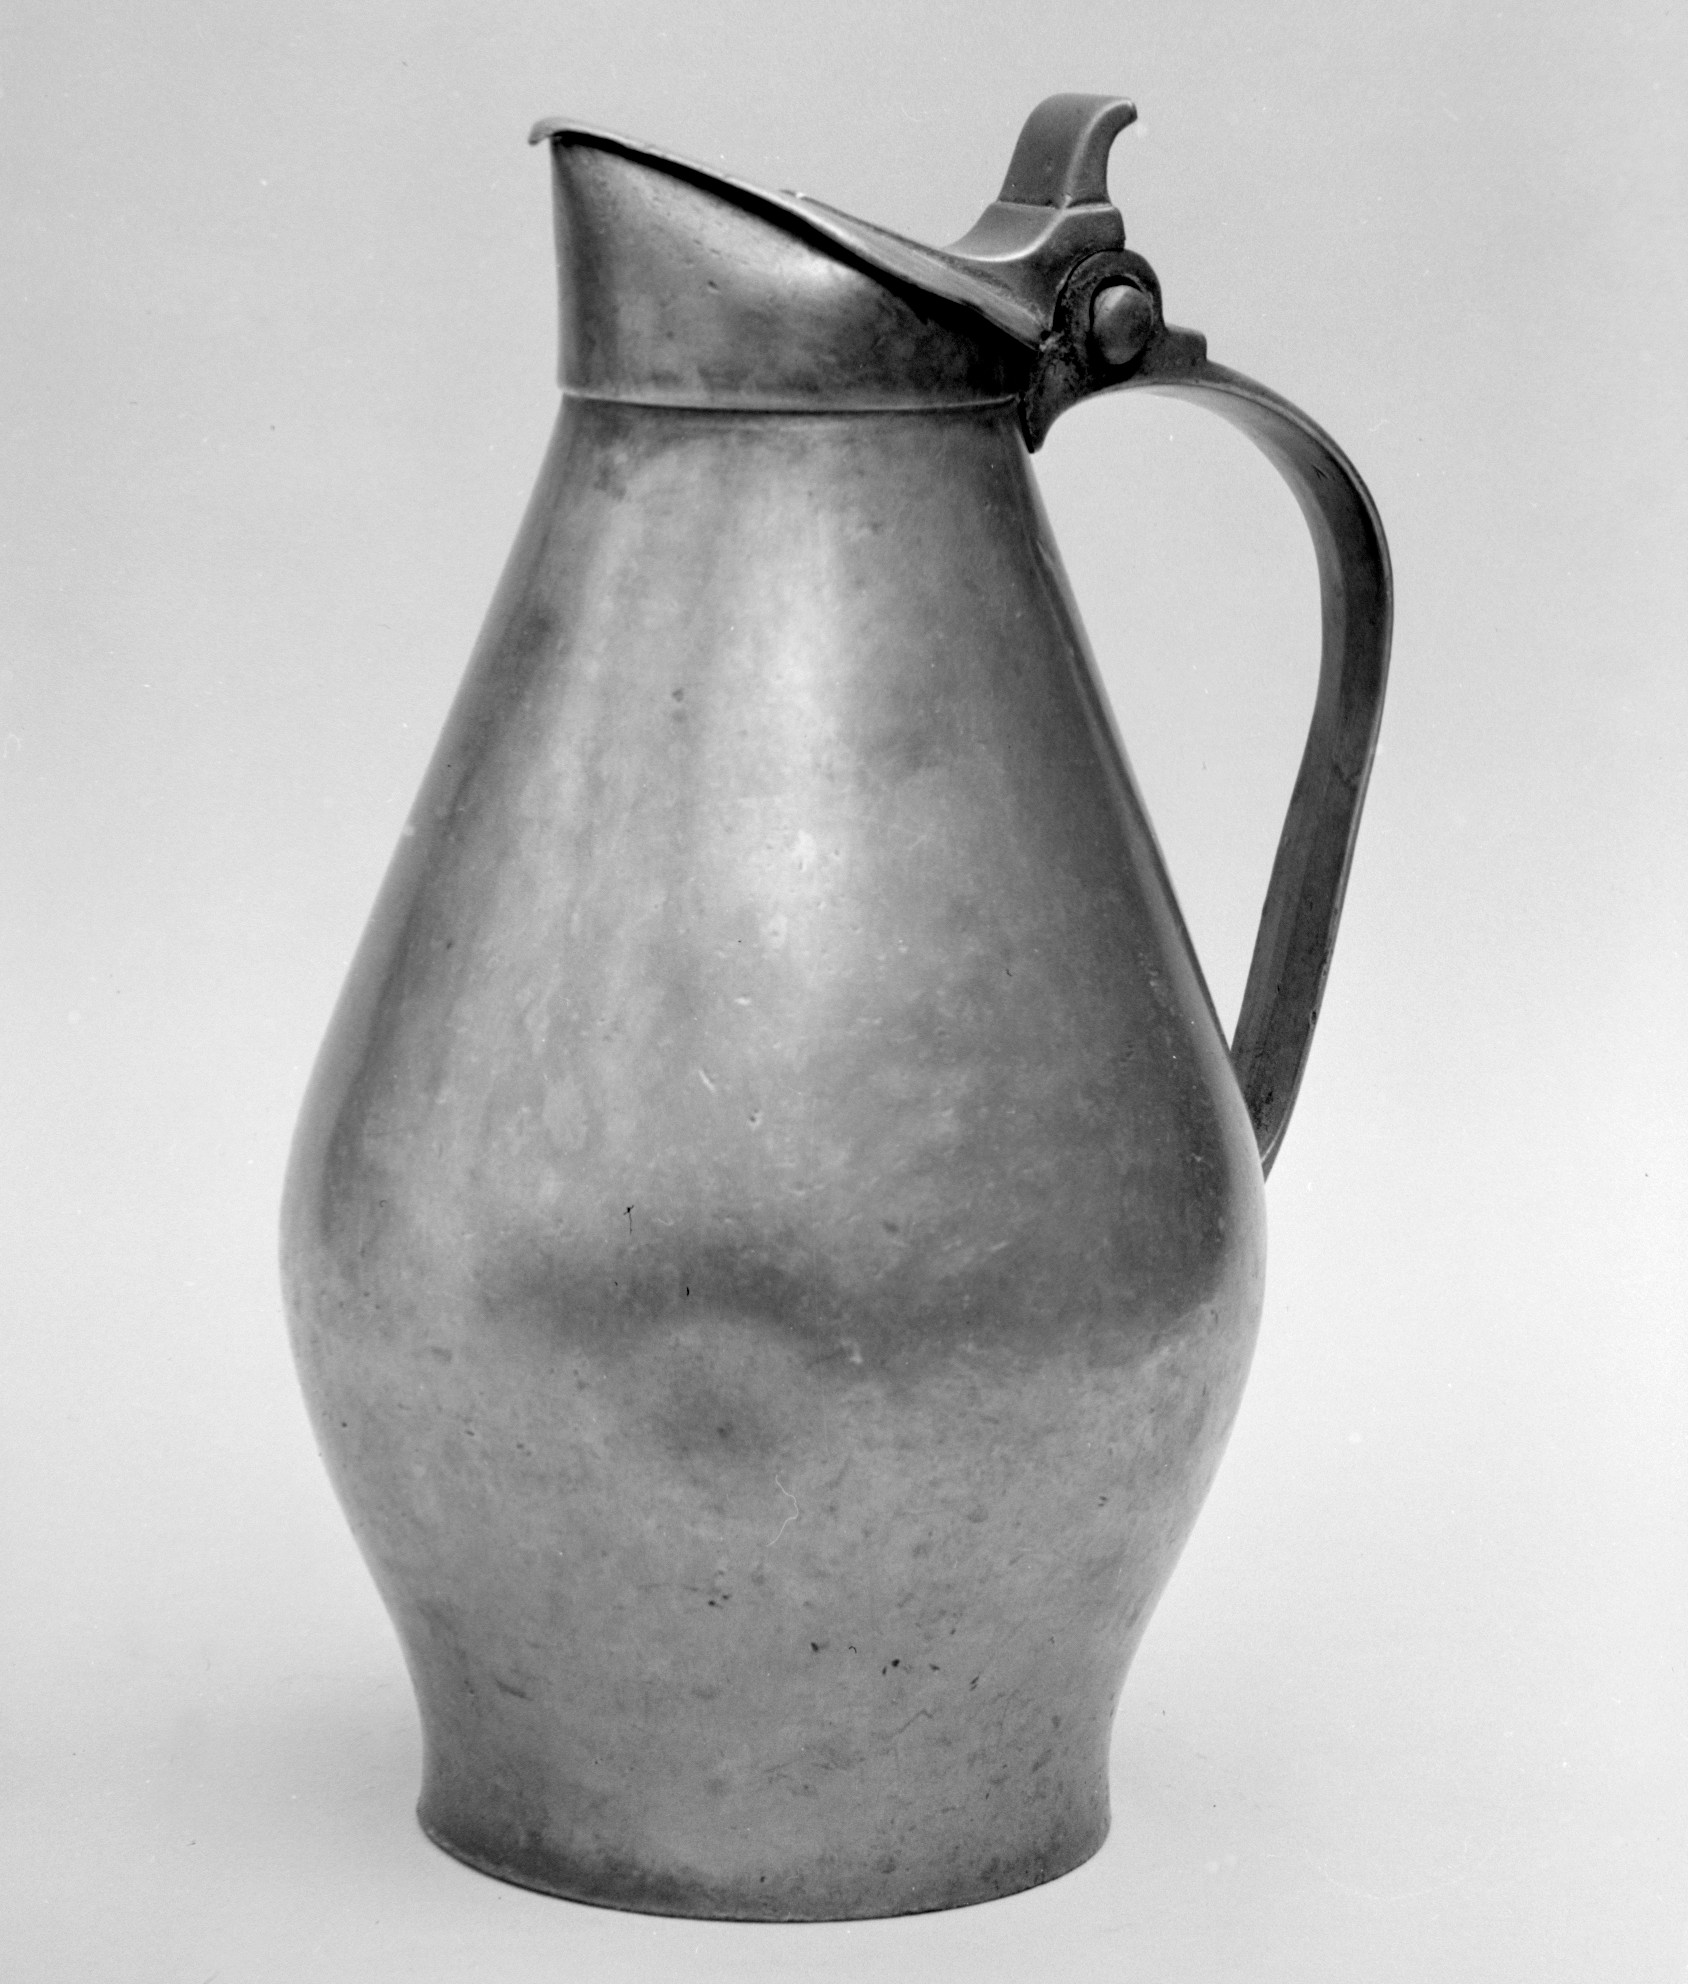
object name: pitcher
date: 1701-1800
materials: pewter